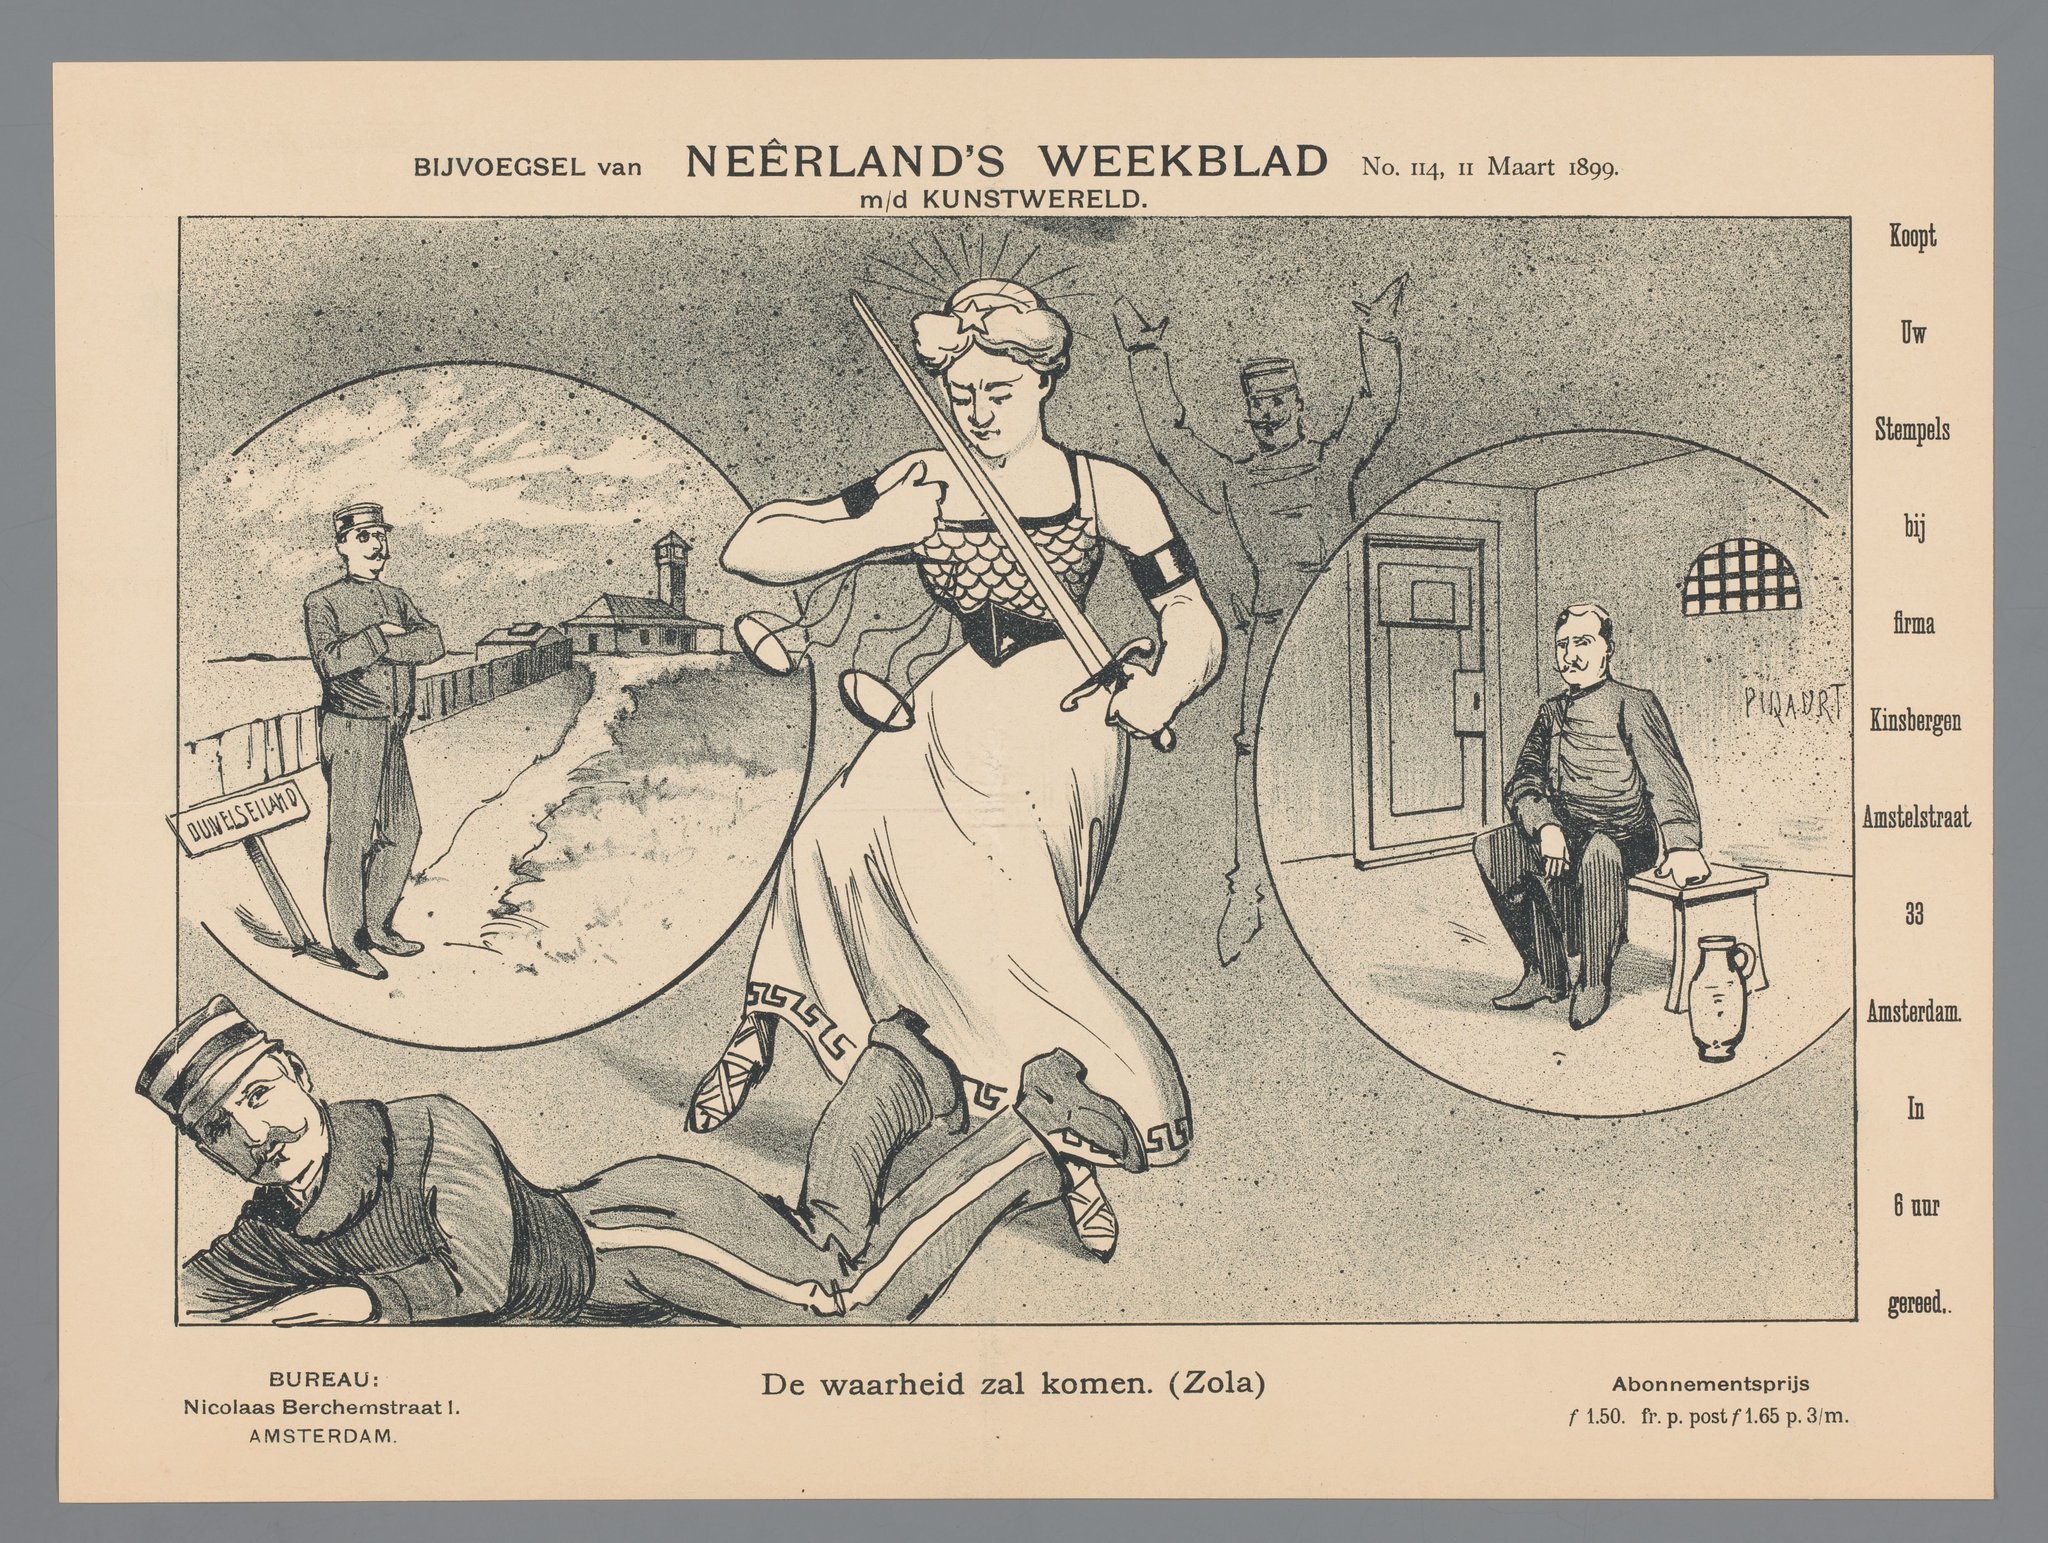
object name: cartoon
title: De waarheid zal komen (Zola)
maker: Anonymous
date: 1899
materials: paper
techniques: lithograph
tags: paris, emile zola, justice, 'justitia'; 'giustitia divina' (ripa) ~ one of the four cardinal virtues, political caricatures and satires, france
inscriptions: date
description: Prent uit het bijvoegsel van: Neêrland’s Weekblad, nr. 114, 11 maart 1899.